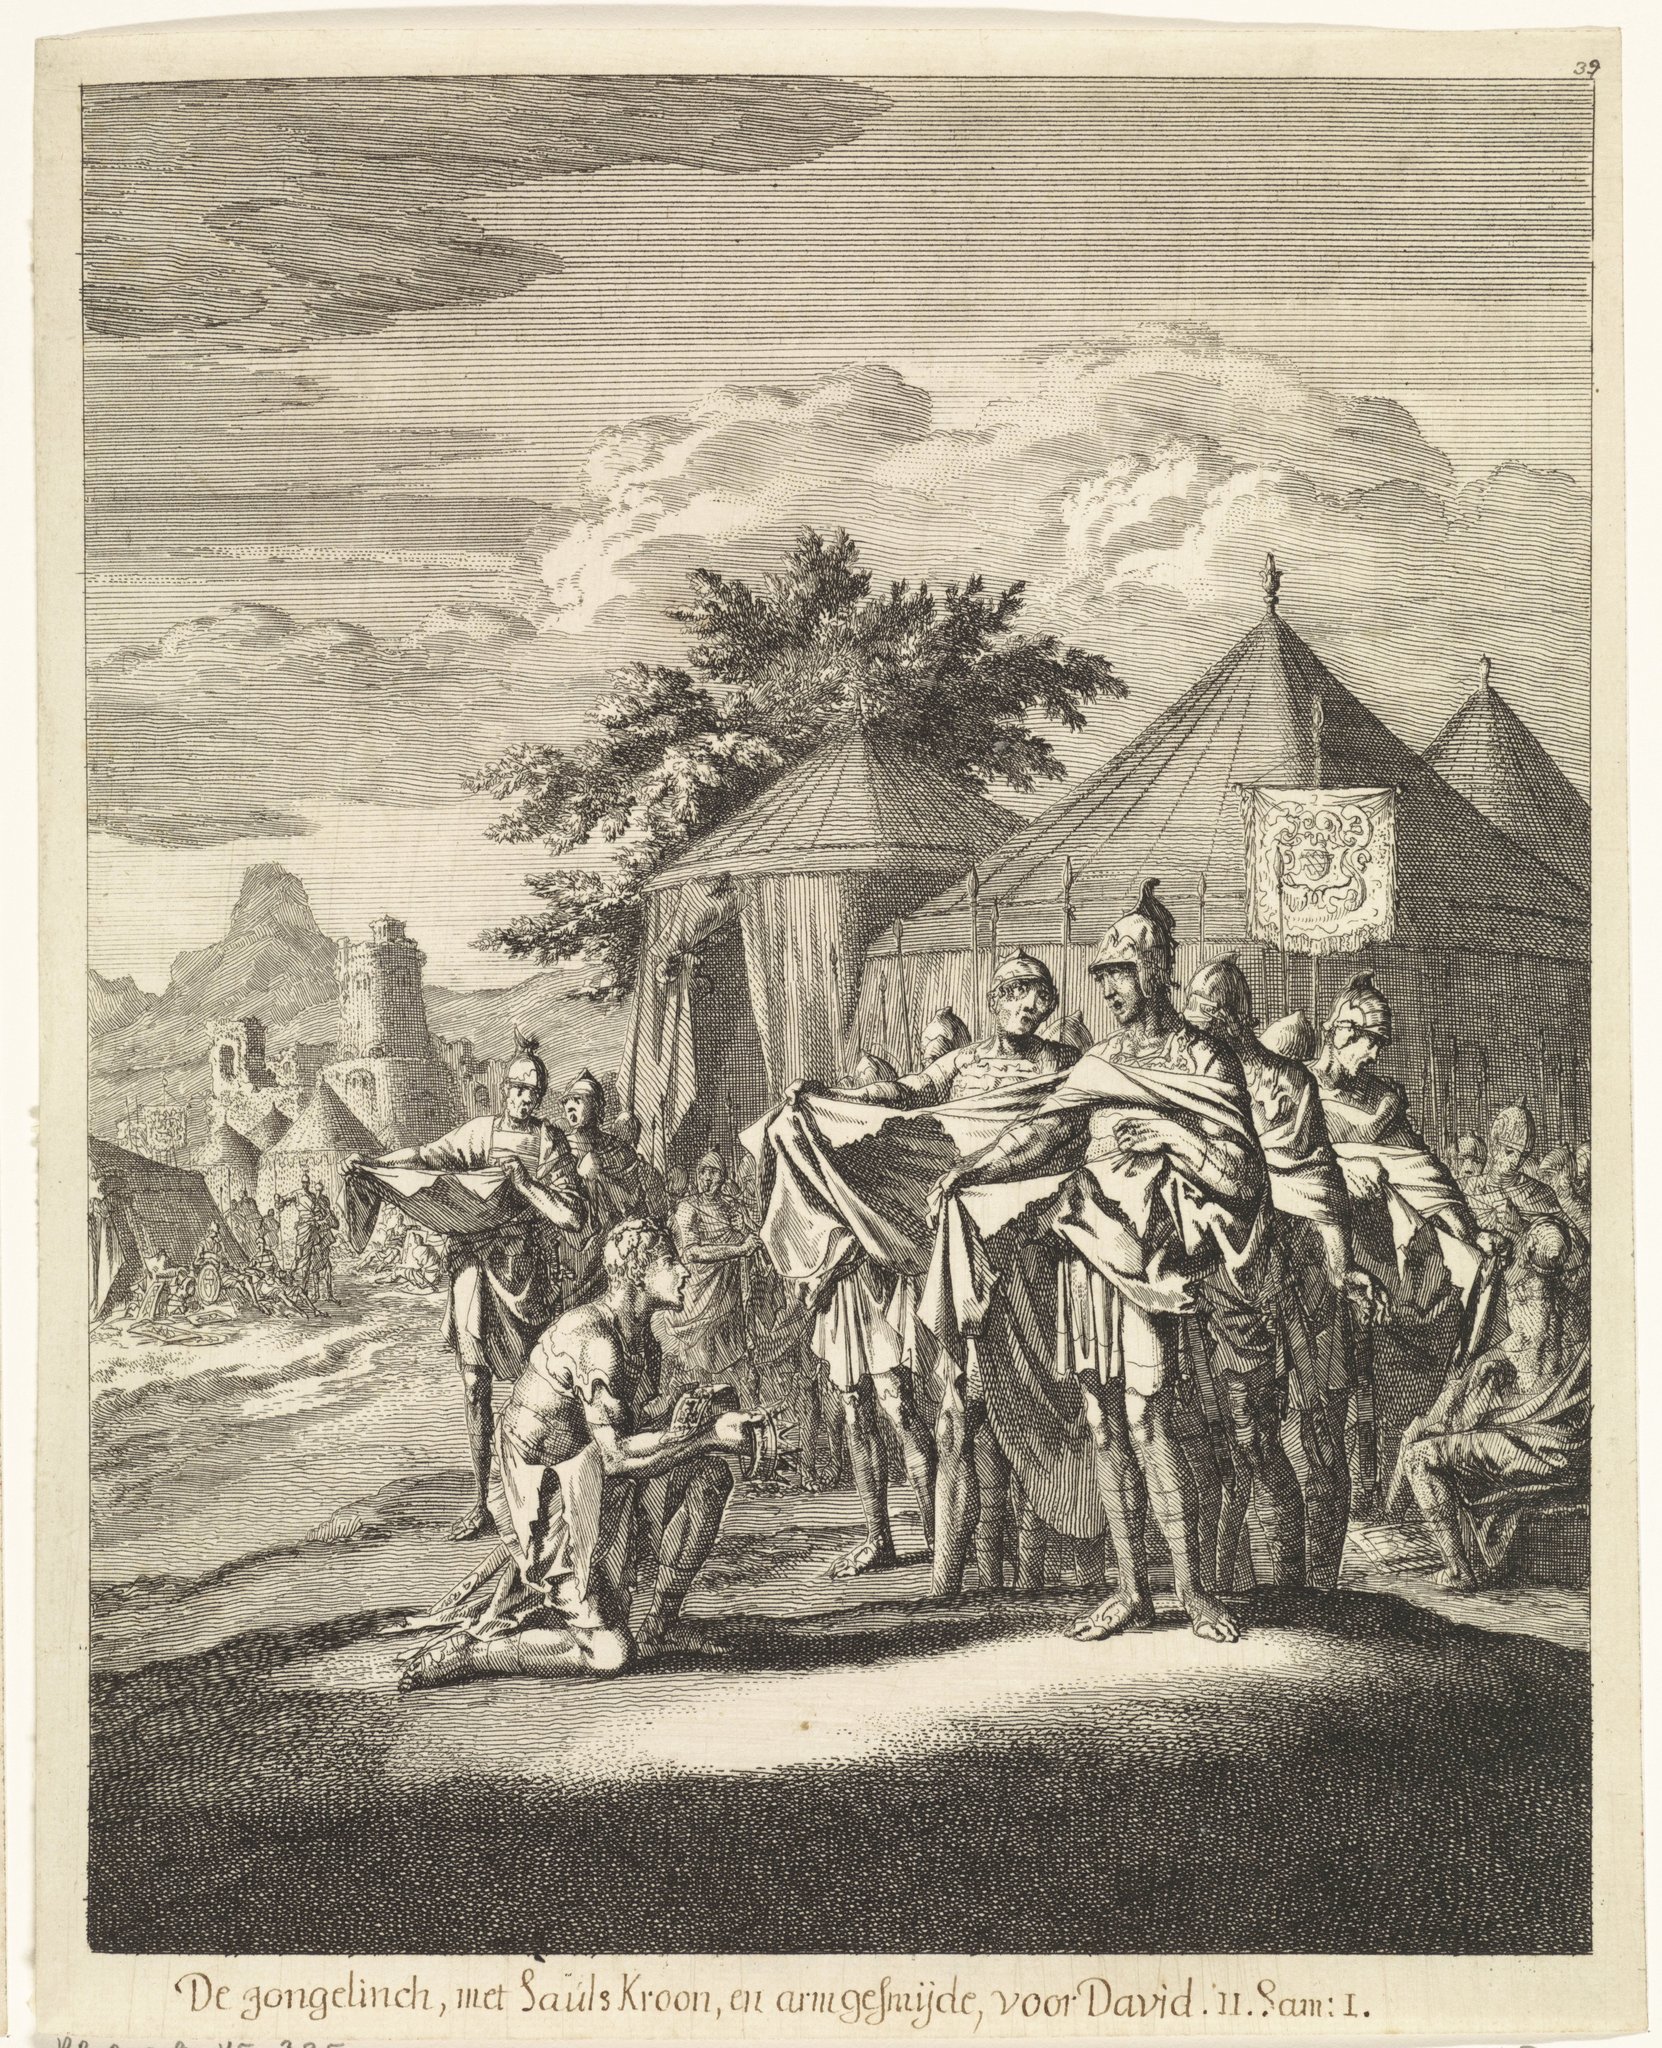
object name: print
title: David hoort van de dood van Saul en Jonatan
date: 1708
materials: paper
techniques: etching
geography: amsterdam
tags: the messenger brings saul's crown and bracelet to david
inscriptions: collector's mark: Lugt 2228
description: Proefdruk van een prent welke is opgenomen als illustratie in: Historiae Celebriores Veteris Testamenti. Christoph Weigel, 1708.